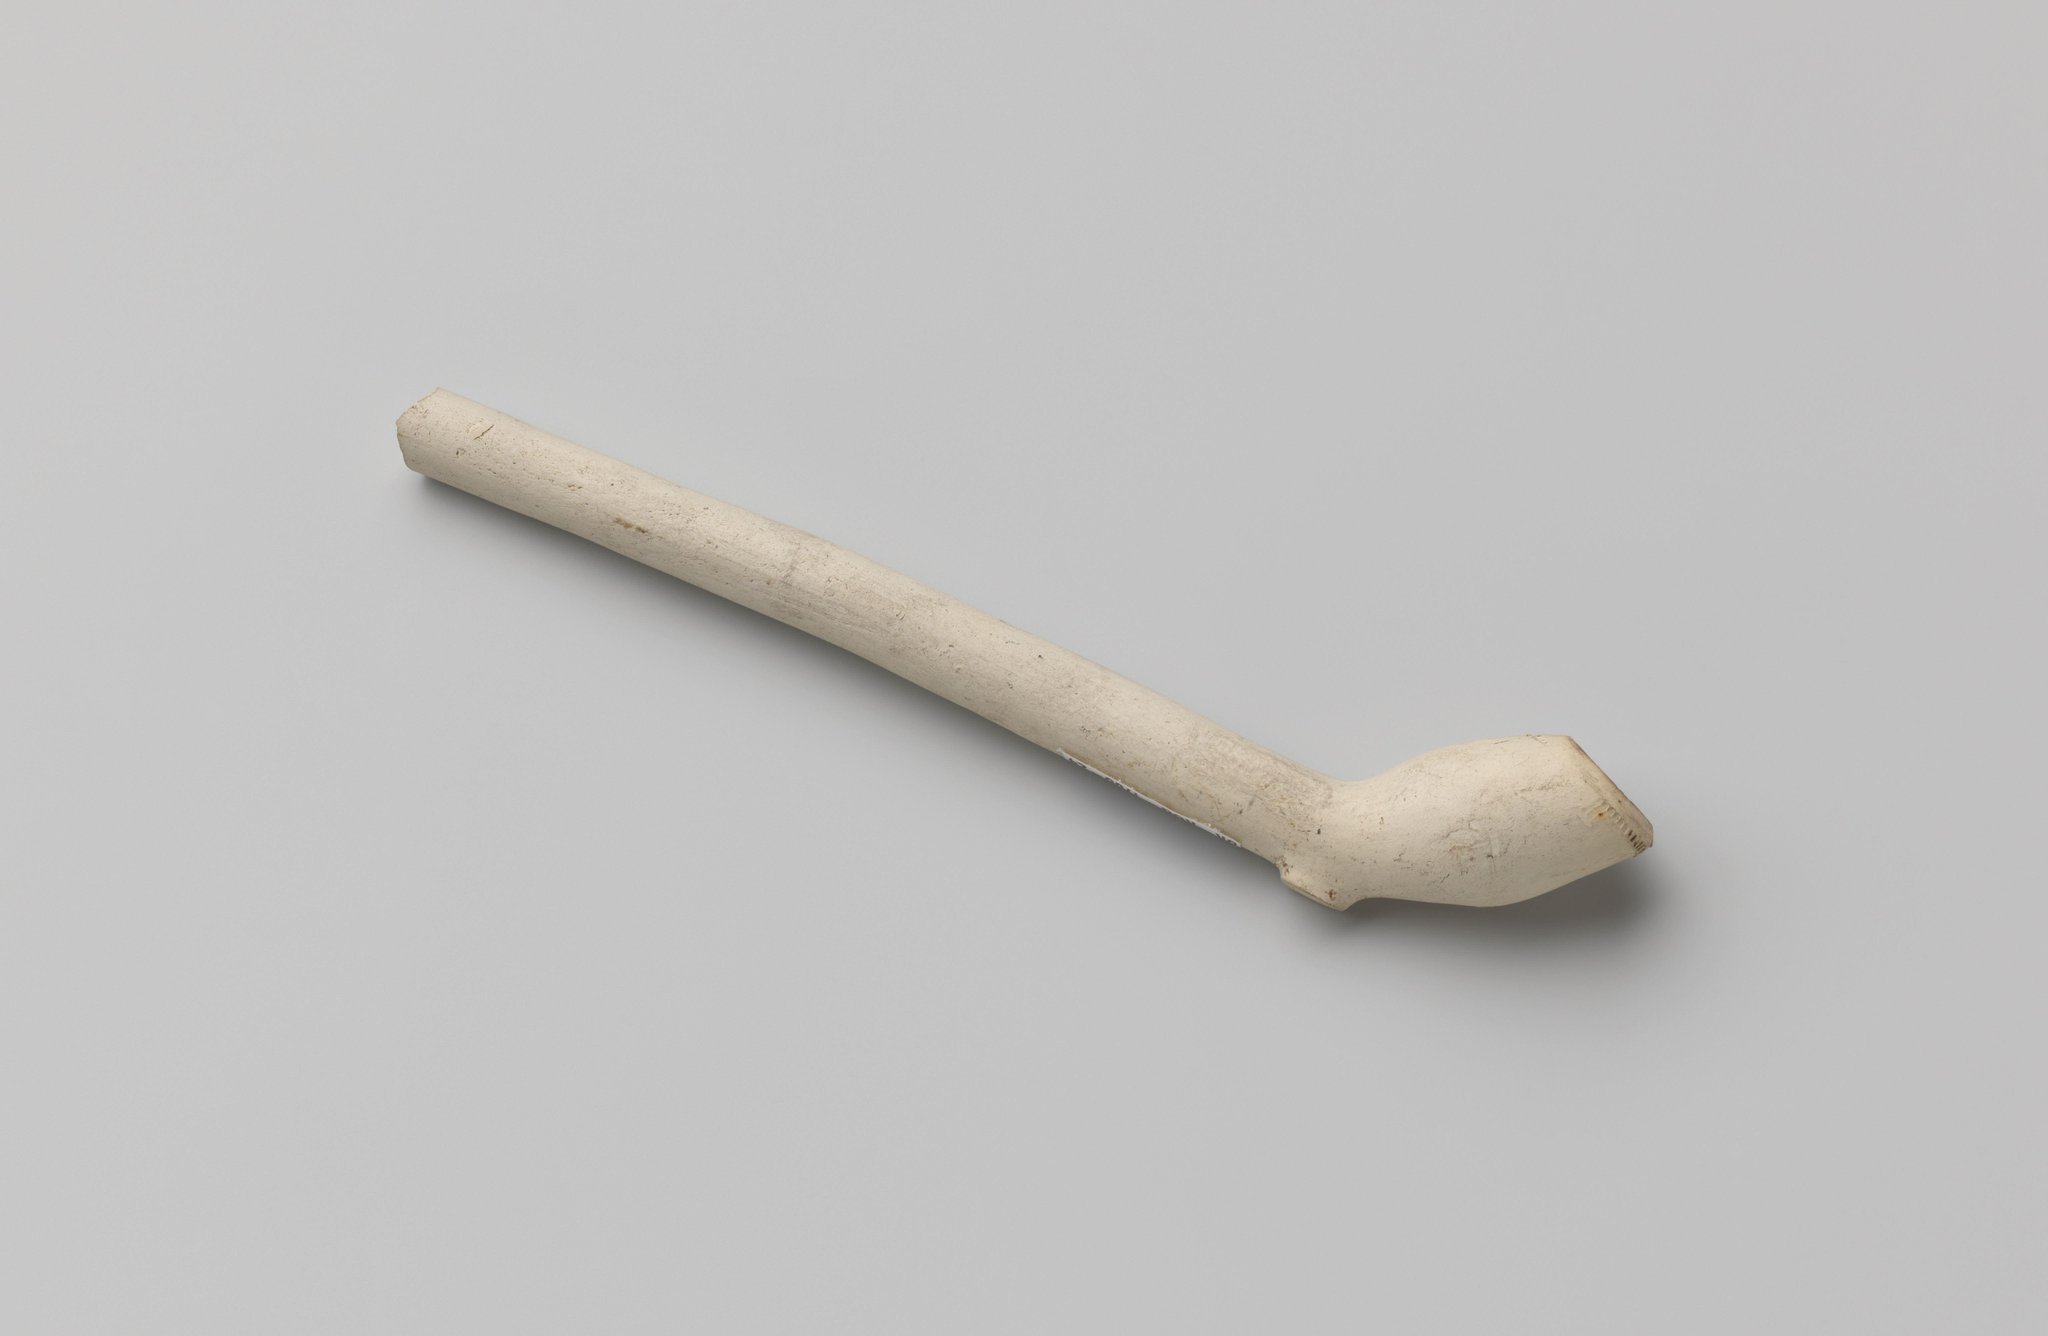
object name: tabakspijp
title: Gemerkte tabakspijp van pijpaarde, beschadigd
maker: Anonymous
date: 1500-1799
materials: clay